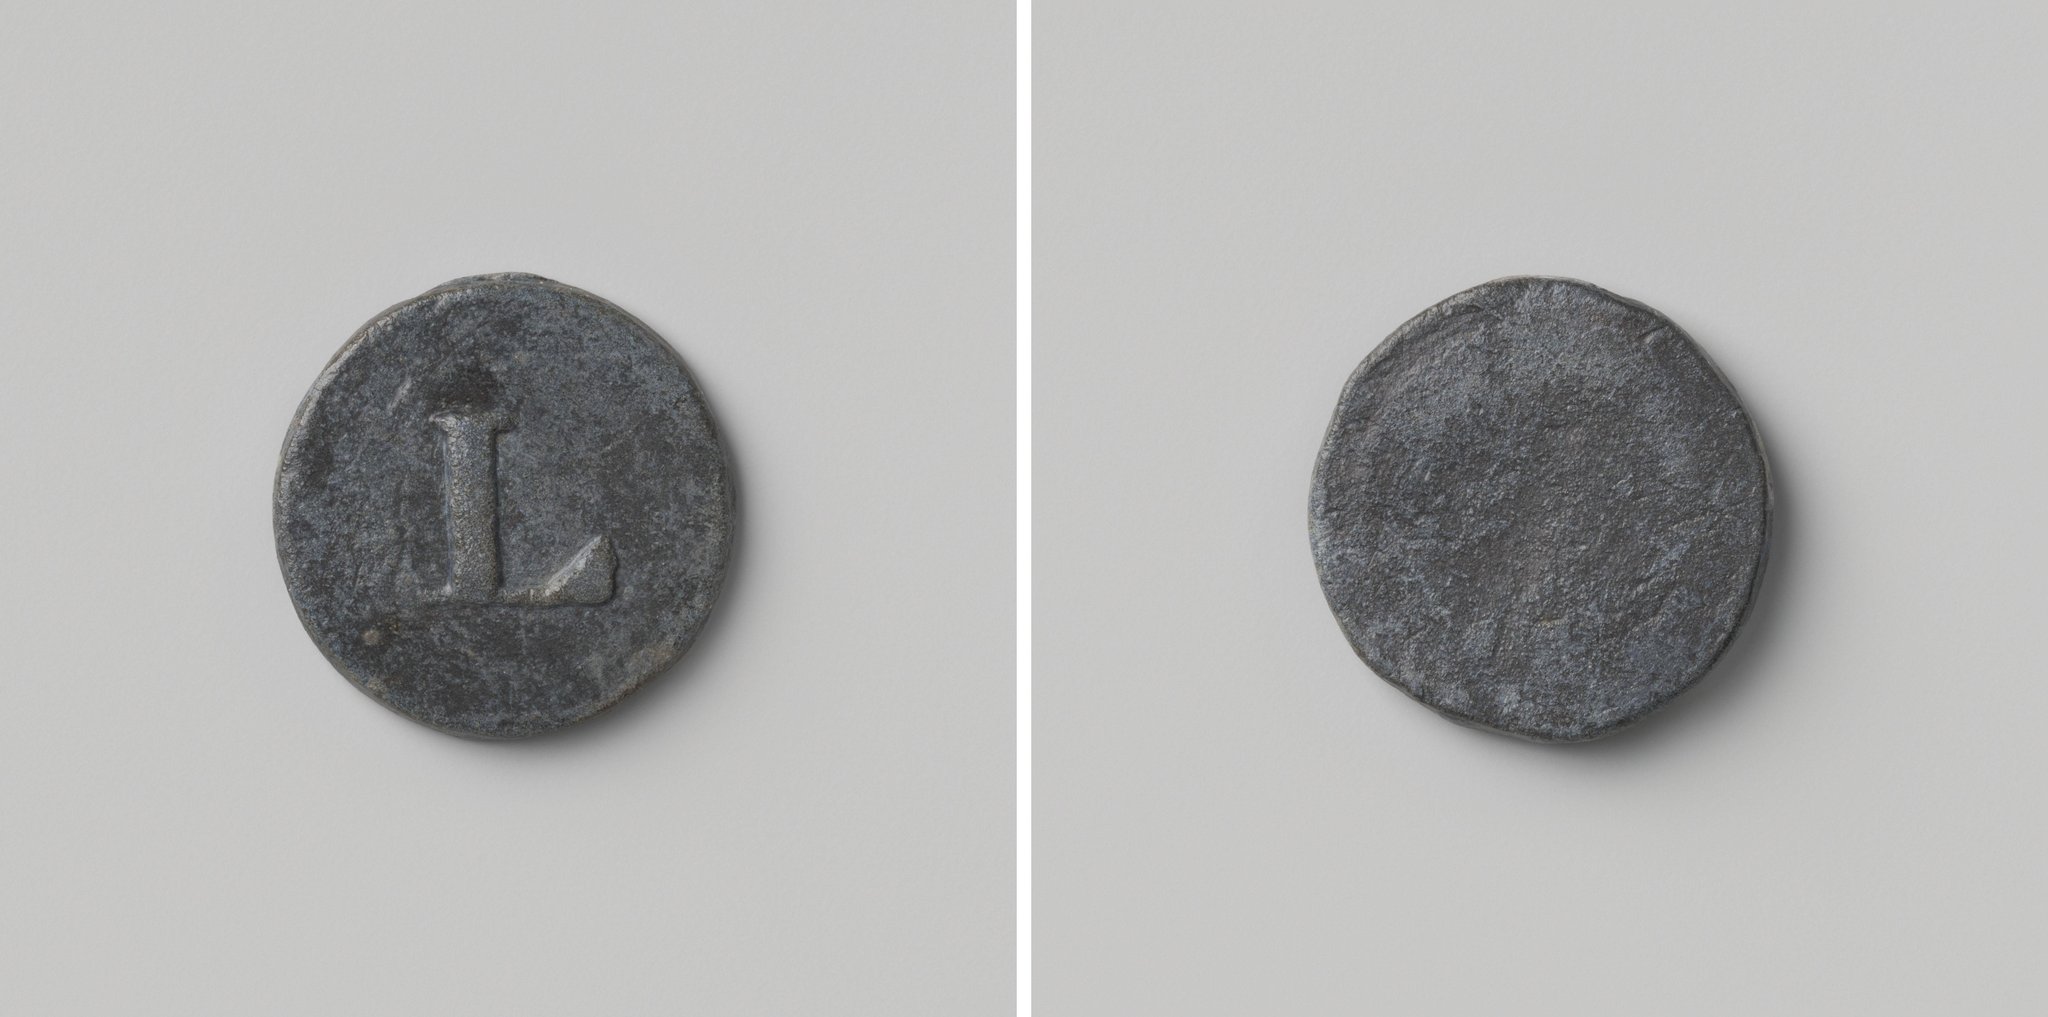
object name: medal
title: Penning met letter L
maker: Anonymous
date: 1800-1850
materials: lead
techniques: casting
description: Eenzijdige loden penning. Voorzijde: letter L. Keerzijde: blanco